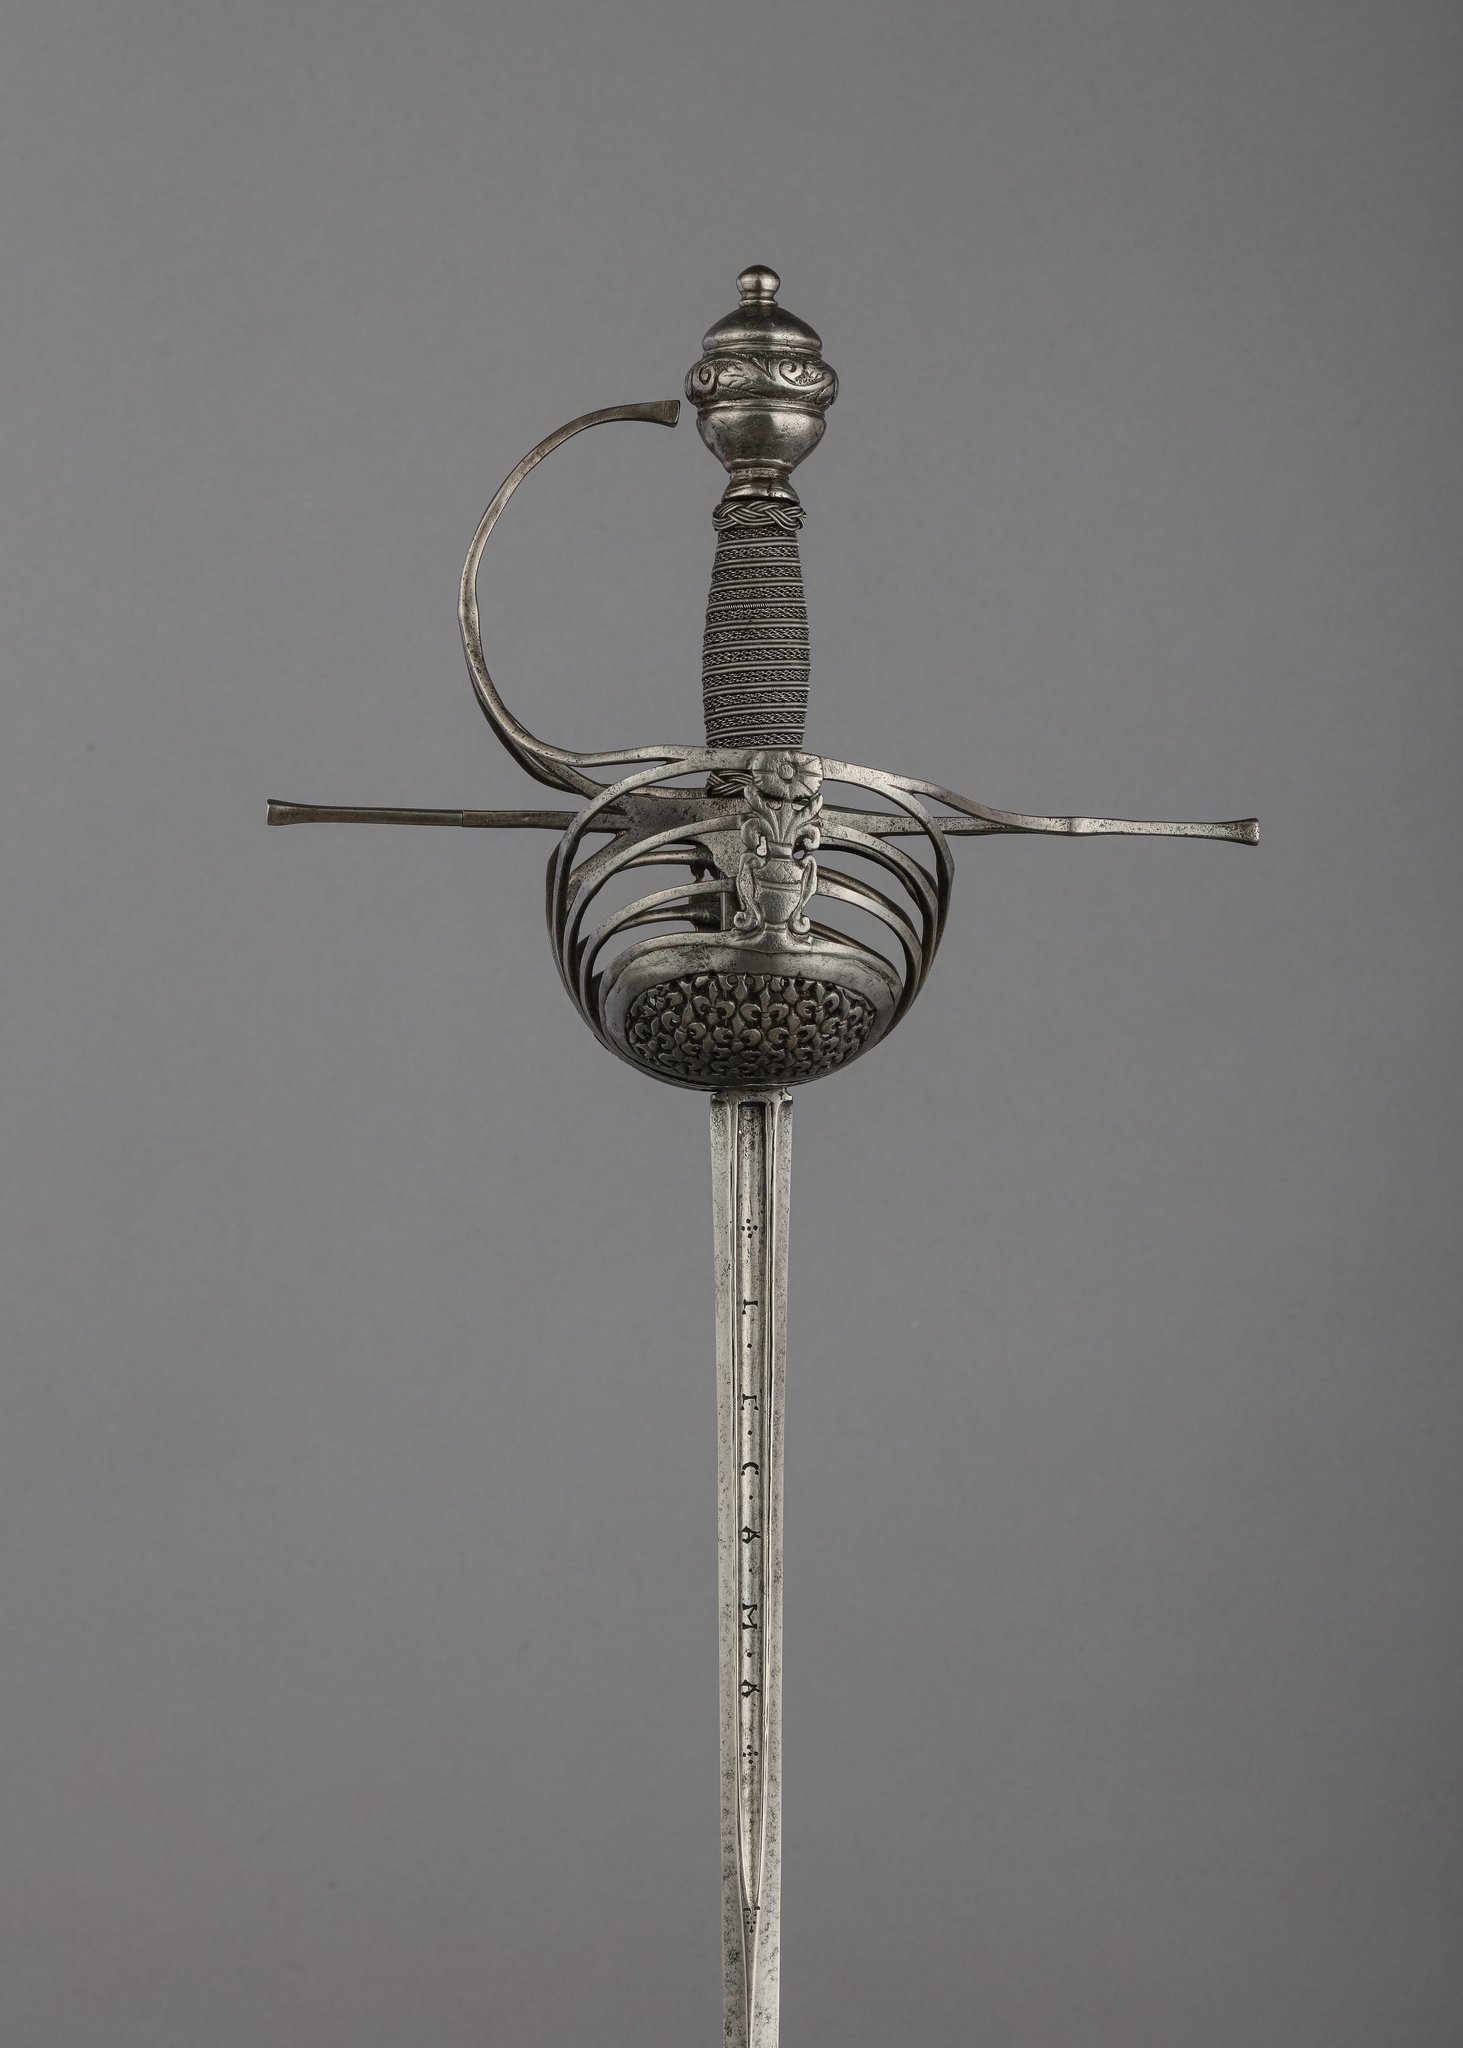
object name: rapier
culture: spanish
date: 1650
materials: steel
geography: spain